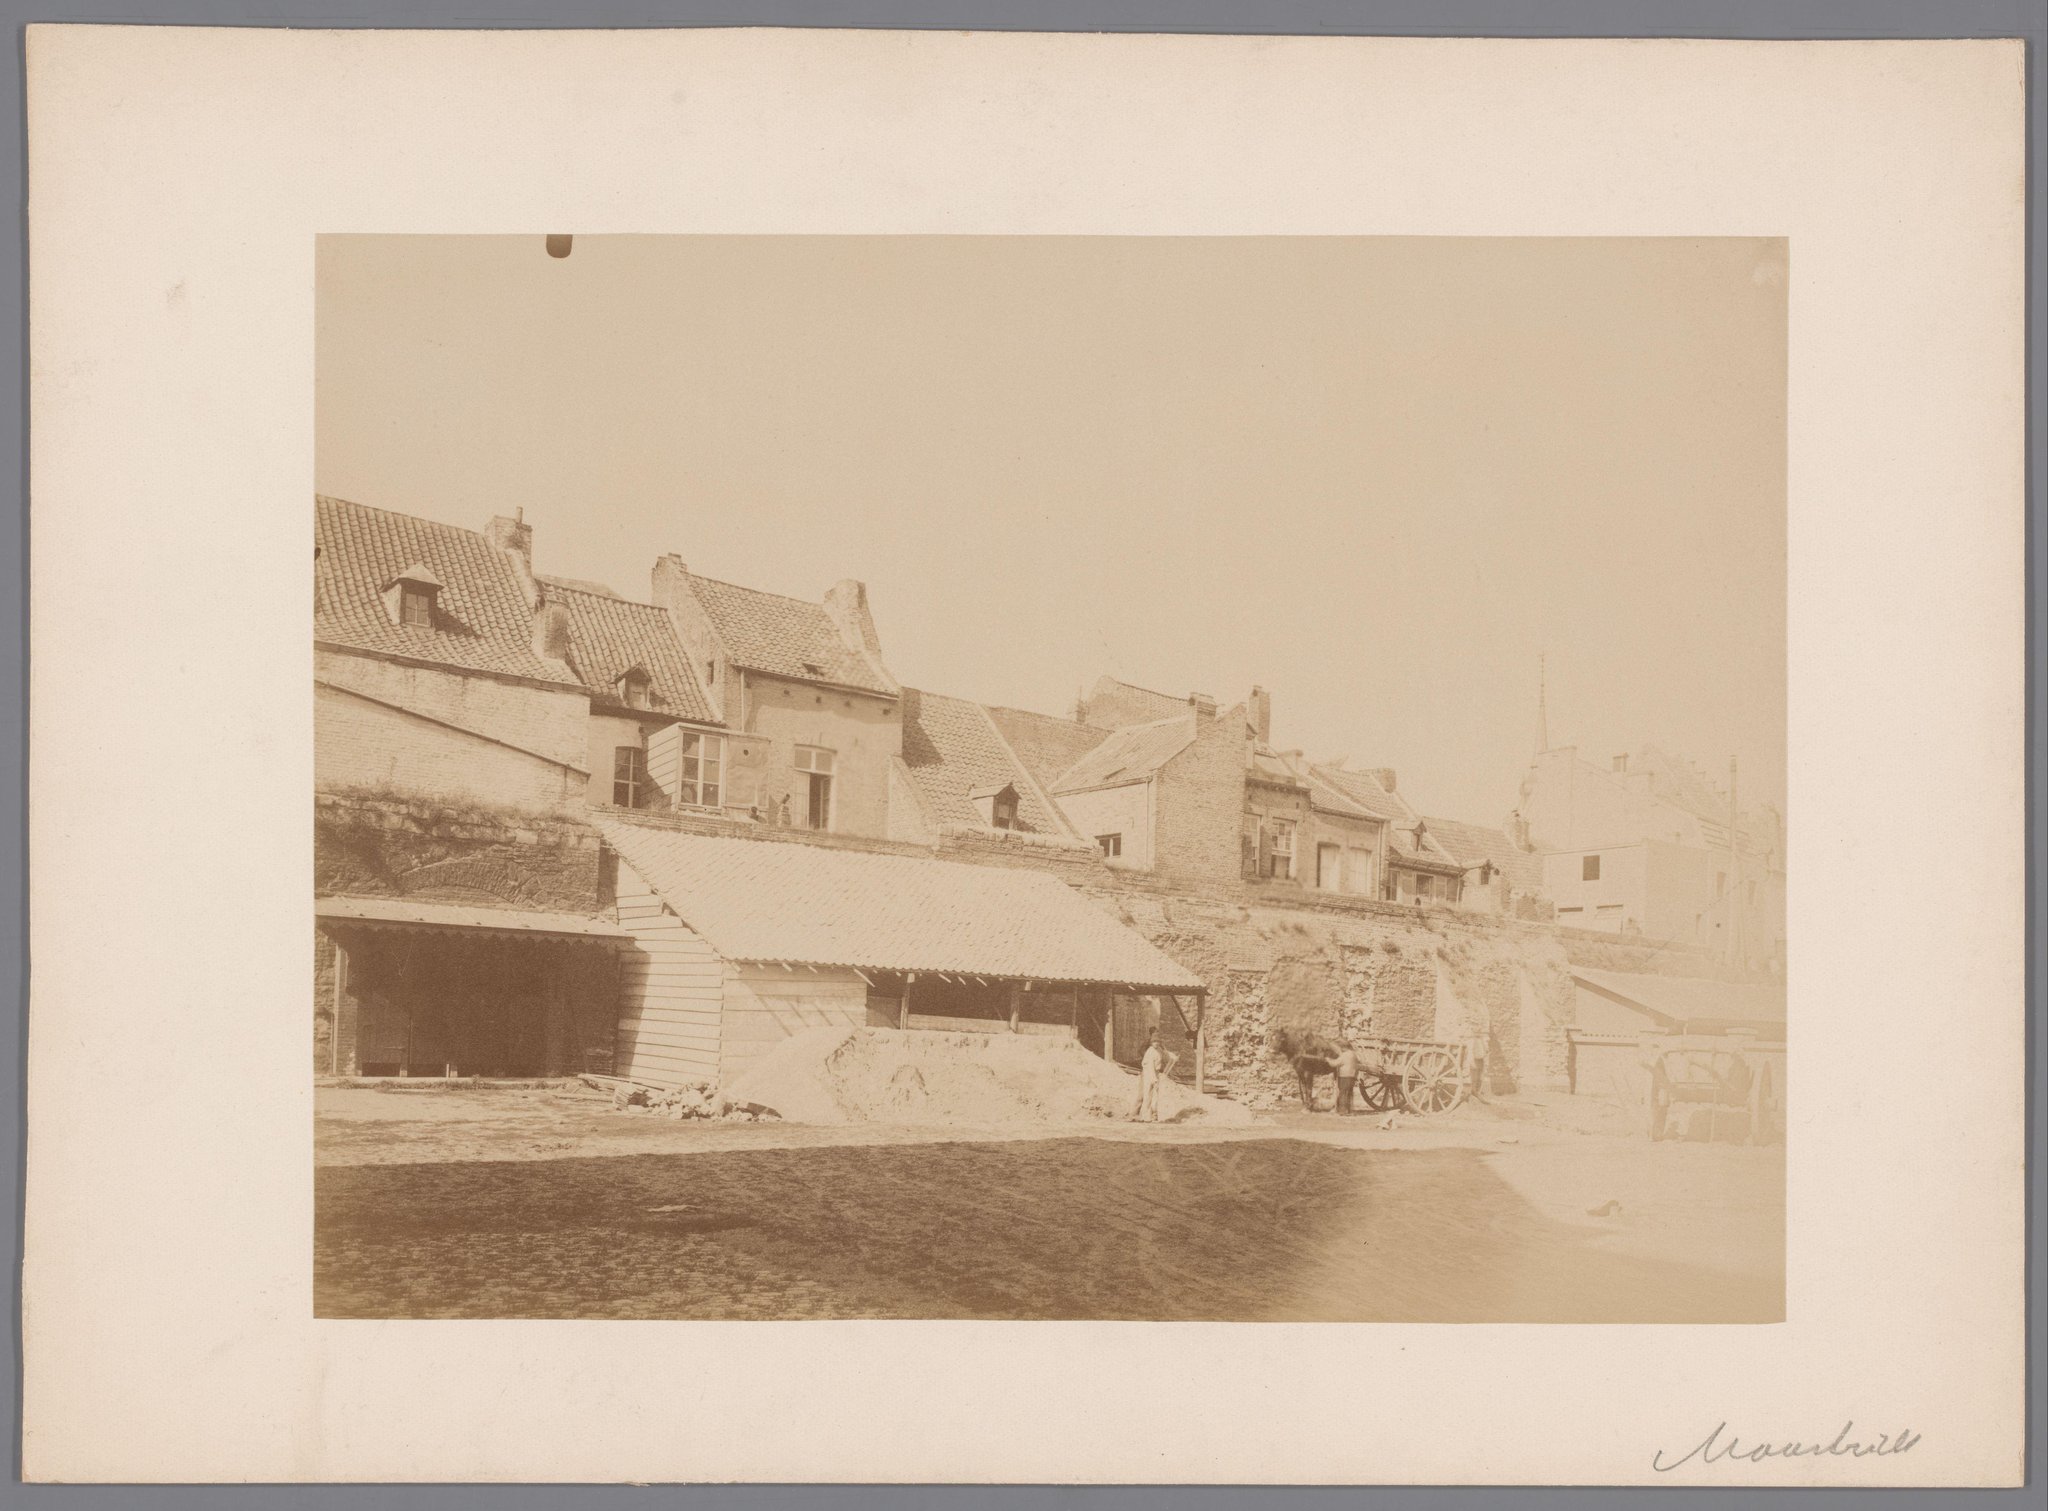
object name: photograph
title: Gezicht op de oude walmuur achter het gymnasium te Maastricht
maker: anoniem (monumentenzorg)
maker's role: fotograaf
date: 1901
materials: cardboard, photographic support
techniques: albumen print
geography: maastricht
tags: urban housing, walls ~ fortified city, maastricht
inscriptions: annotation: ‘Maastricht (L.)/ oude walmuur achter het gymnasium/ Aug 1901’, annotation: ‘Maastricht’